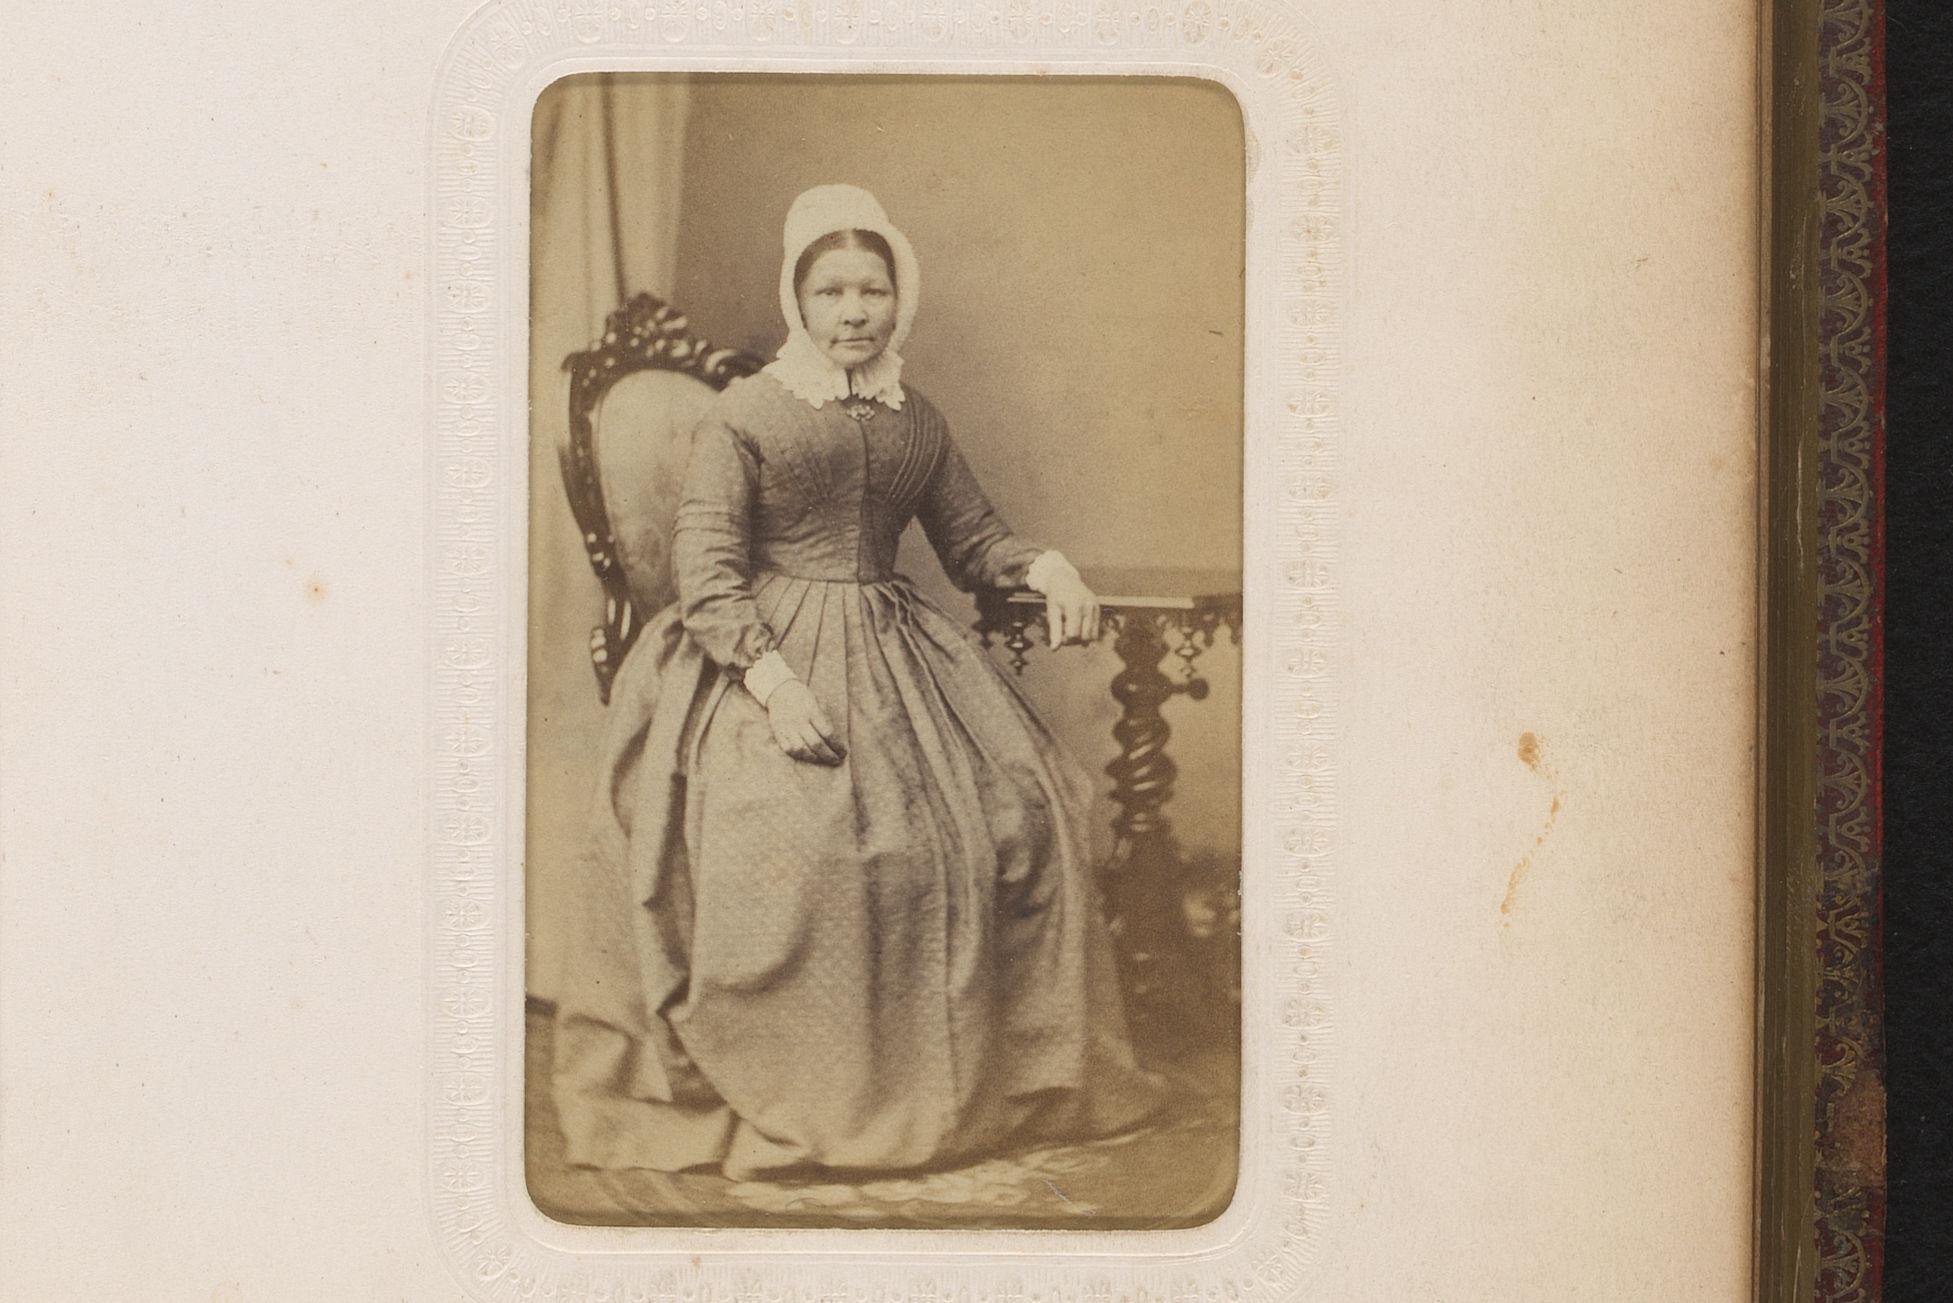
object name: photograph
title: Portret van een zittende vrouw met witte muts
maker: Anonymous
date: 1860-1900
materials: cardboard, photographic support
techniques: albumen print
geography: netherlands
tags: sitting figure - aa - female human figure, historical persons - bb - woman, head-gear: cap